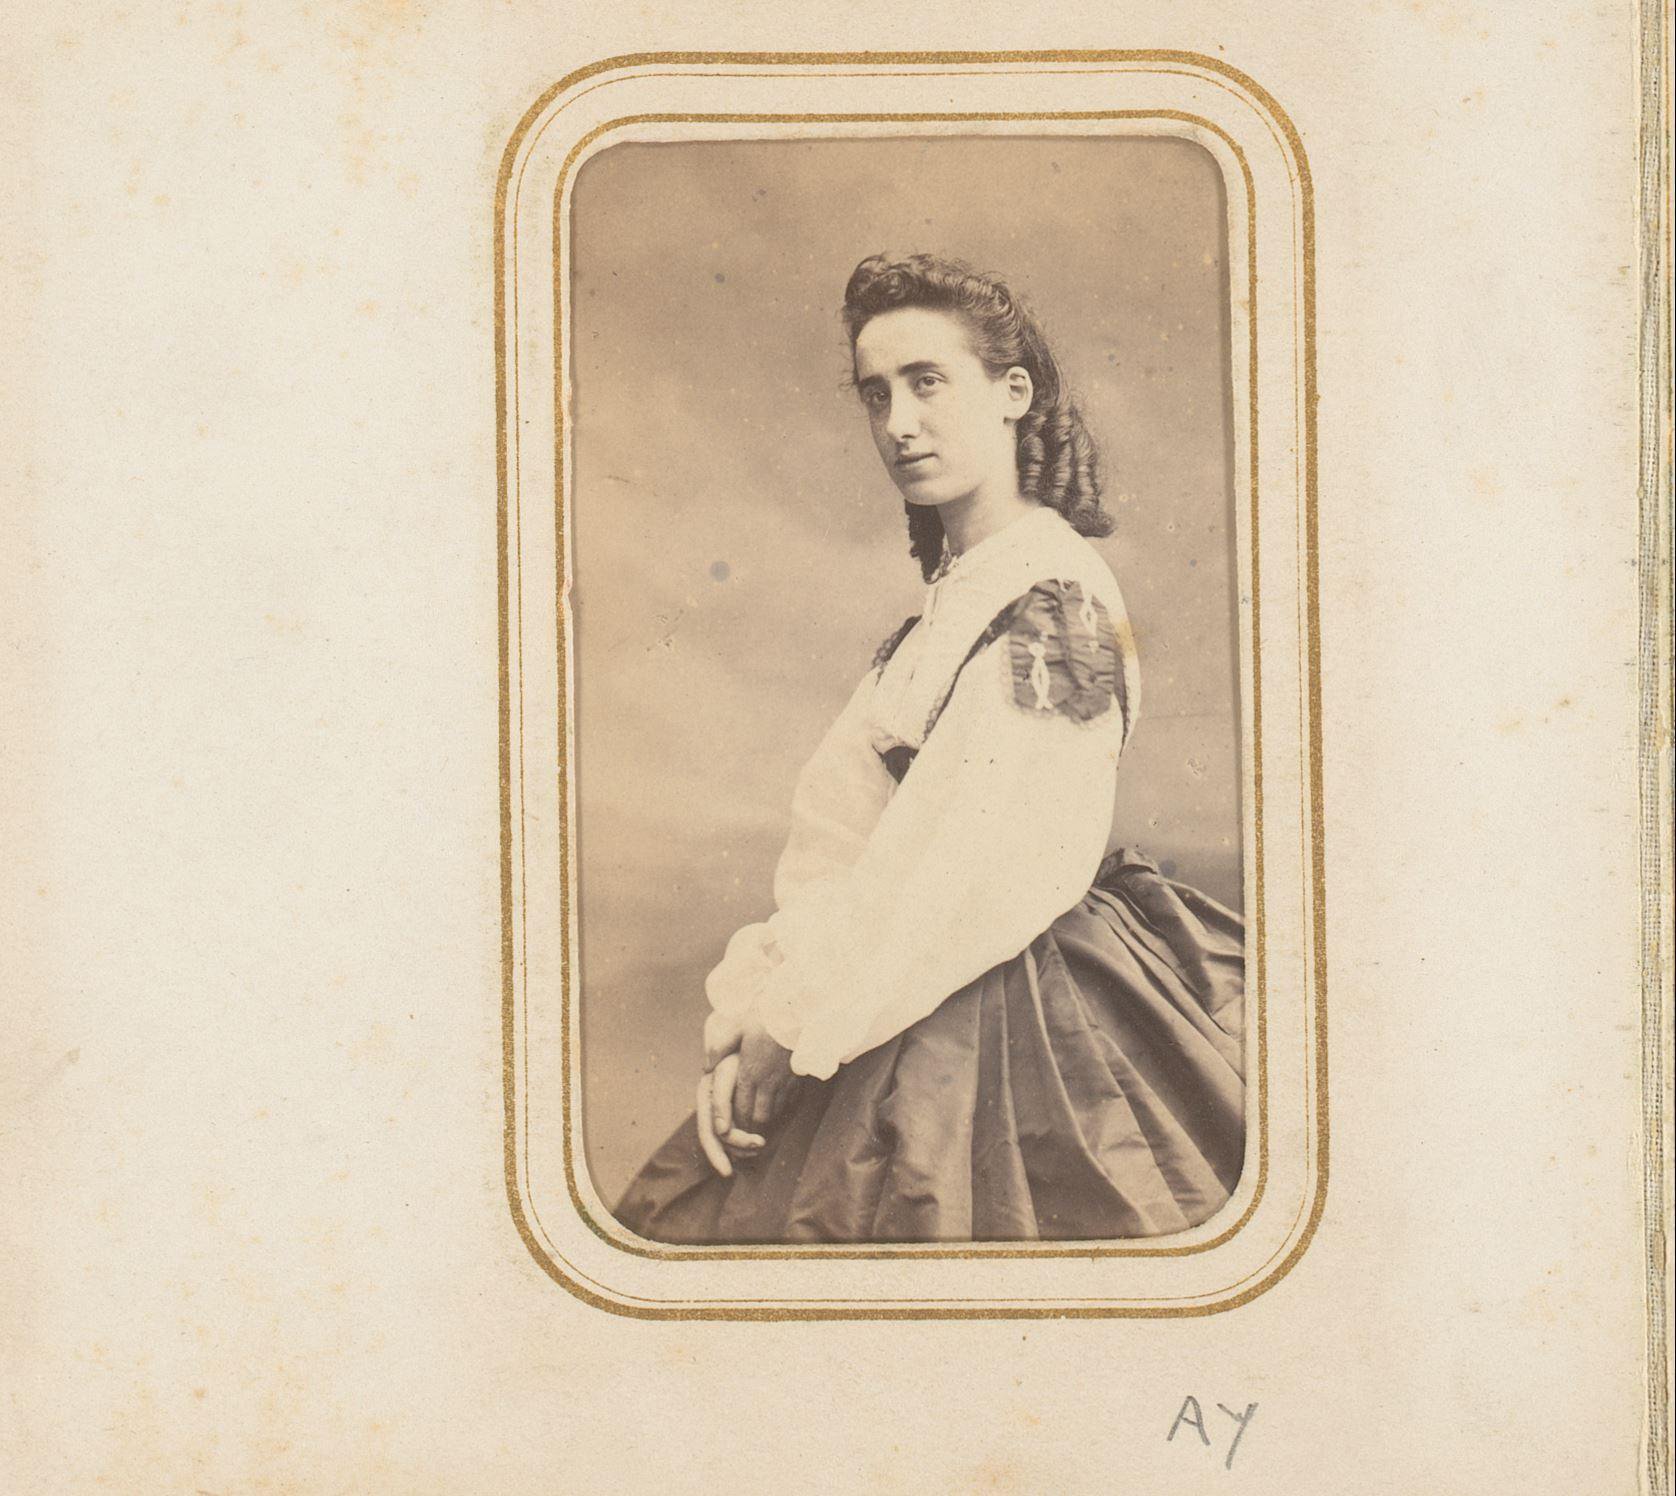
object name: album leaf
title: Portret van een jonge vrouw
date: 1857-1864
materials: cardboard, photographic support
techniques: albumen print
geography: amsterdam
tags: adolescent, young woman, maiden, historical persons - bb - woman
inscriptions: inscription: ‘Photogr. Atelier/ Wegner & Mottu/ Prinsengracht BB 439/ Amsterdam’